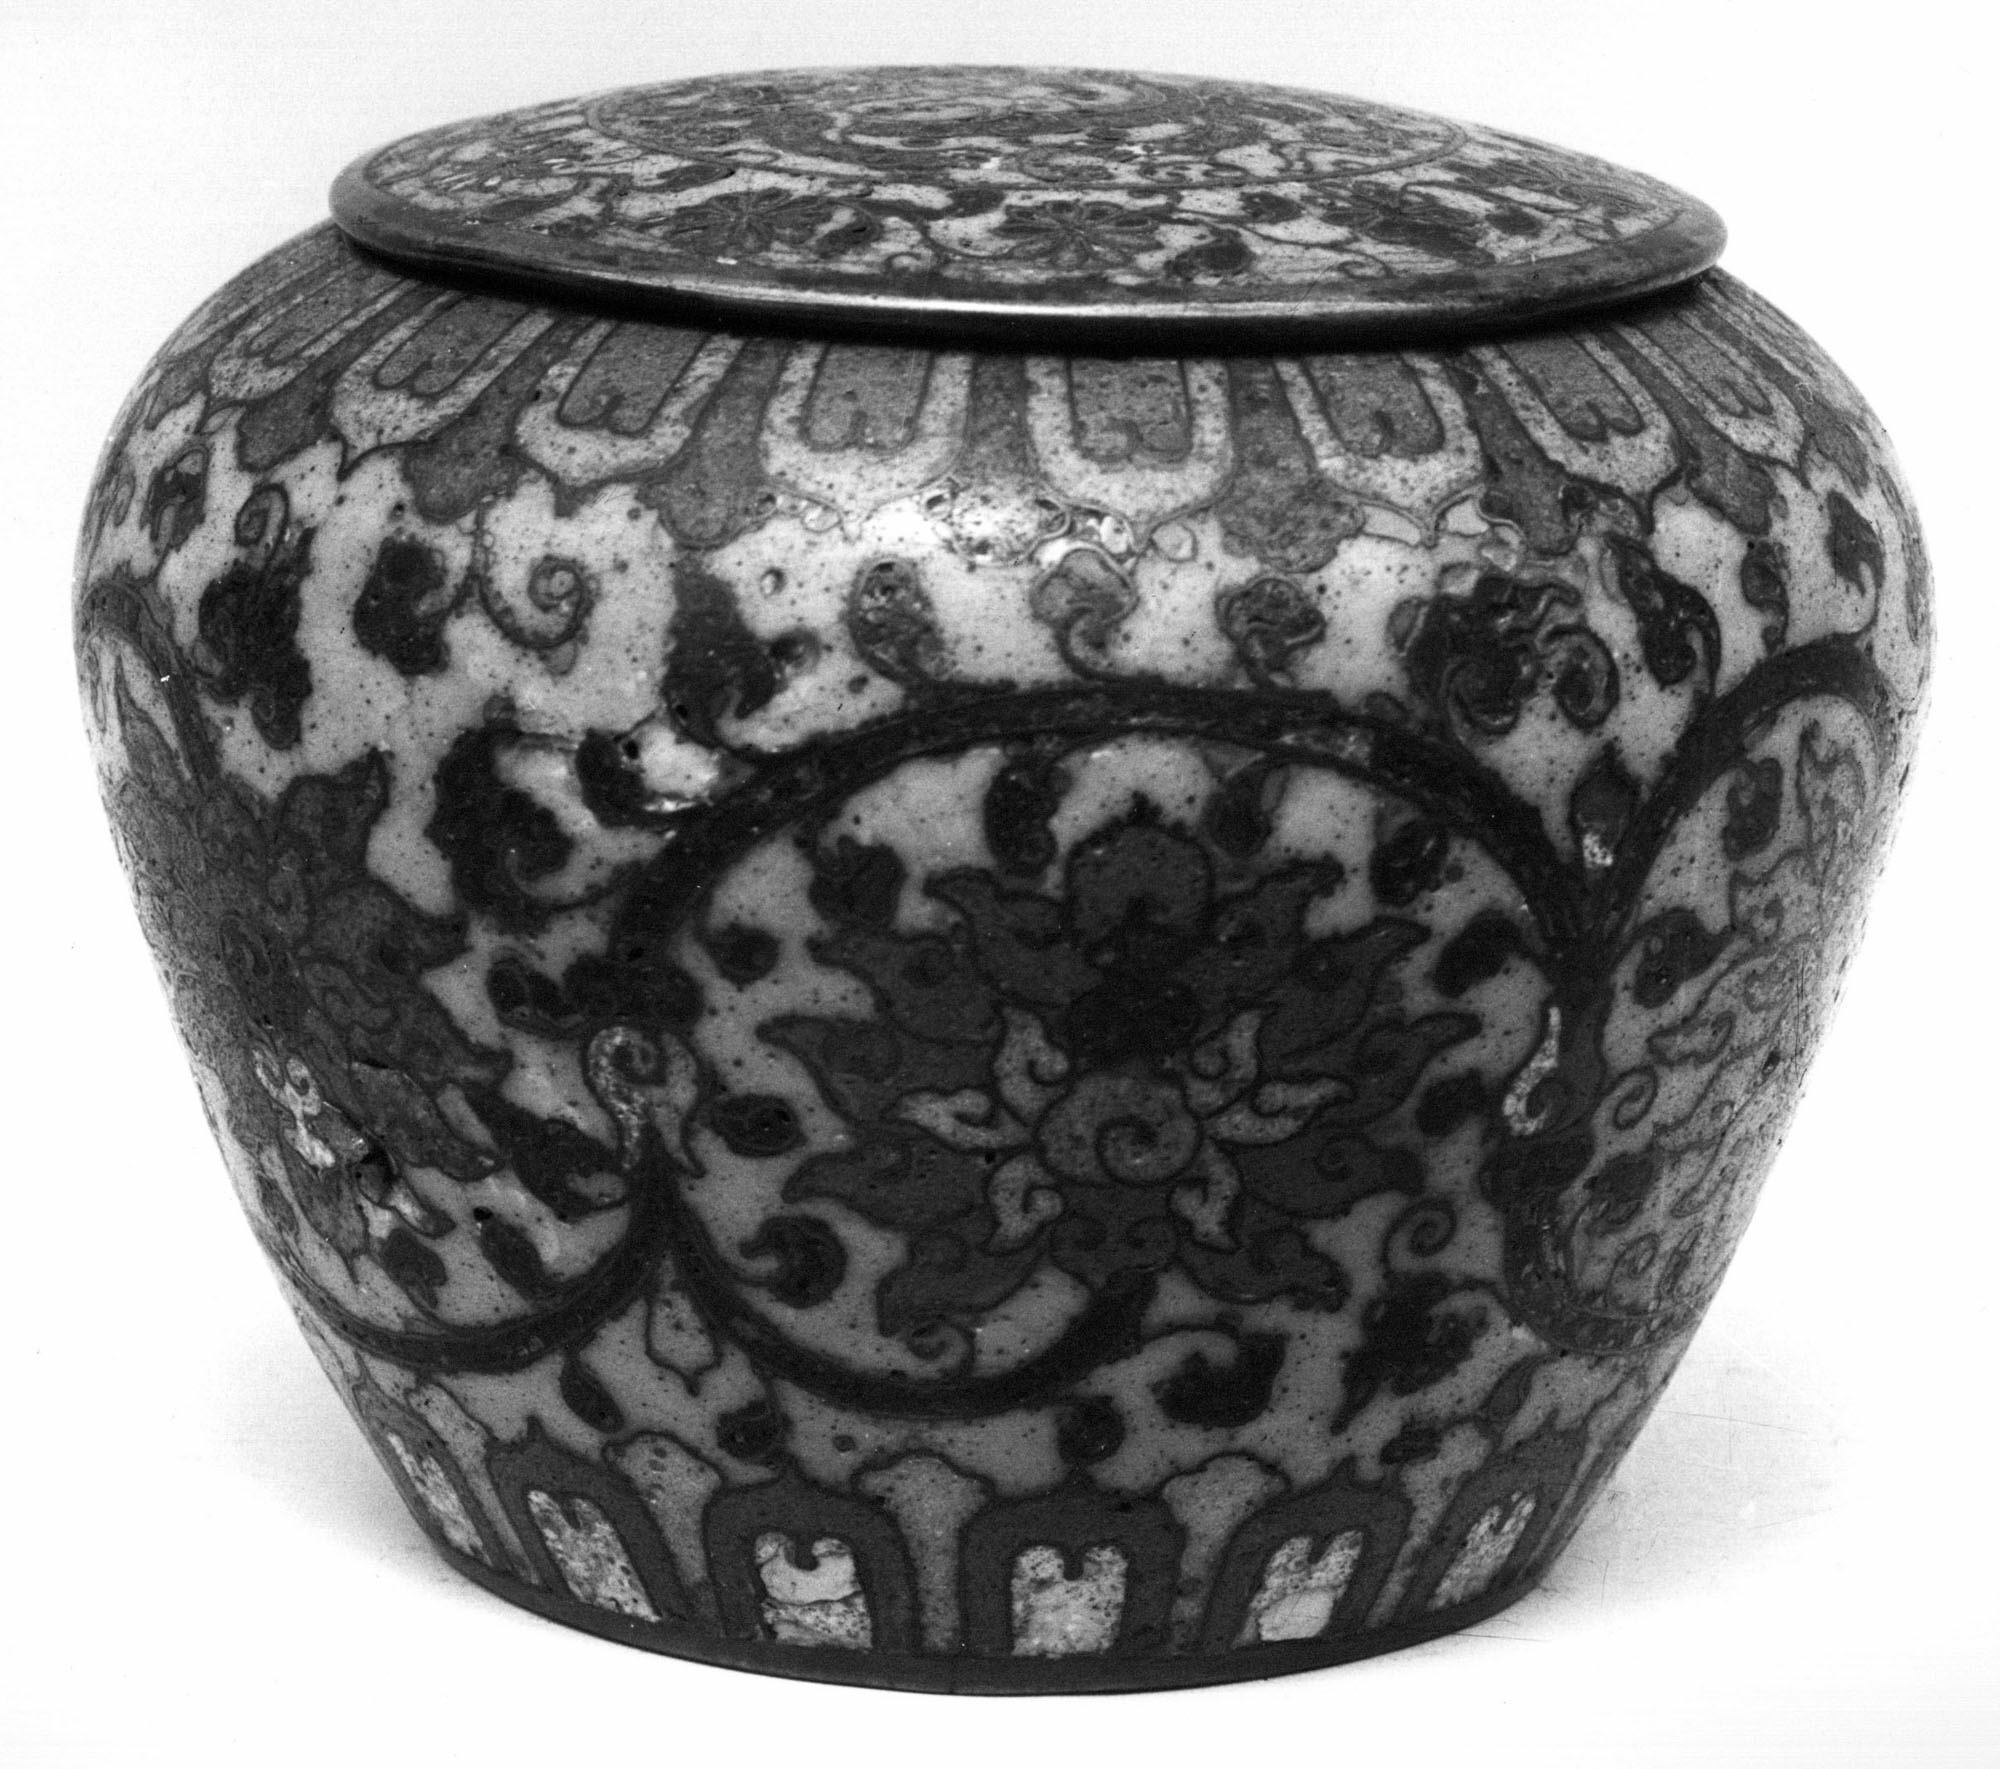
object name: bowl with cover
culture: chinese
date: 1567-1633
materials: enamel